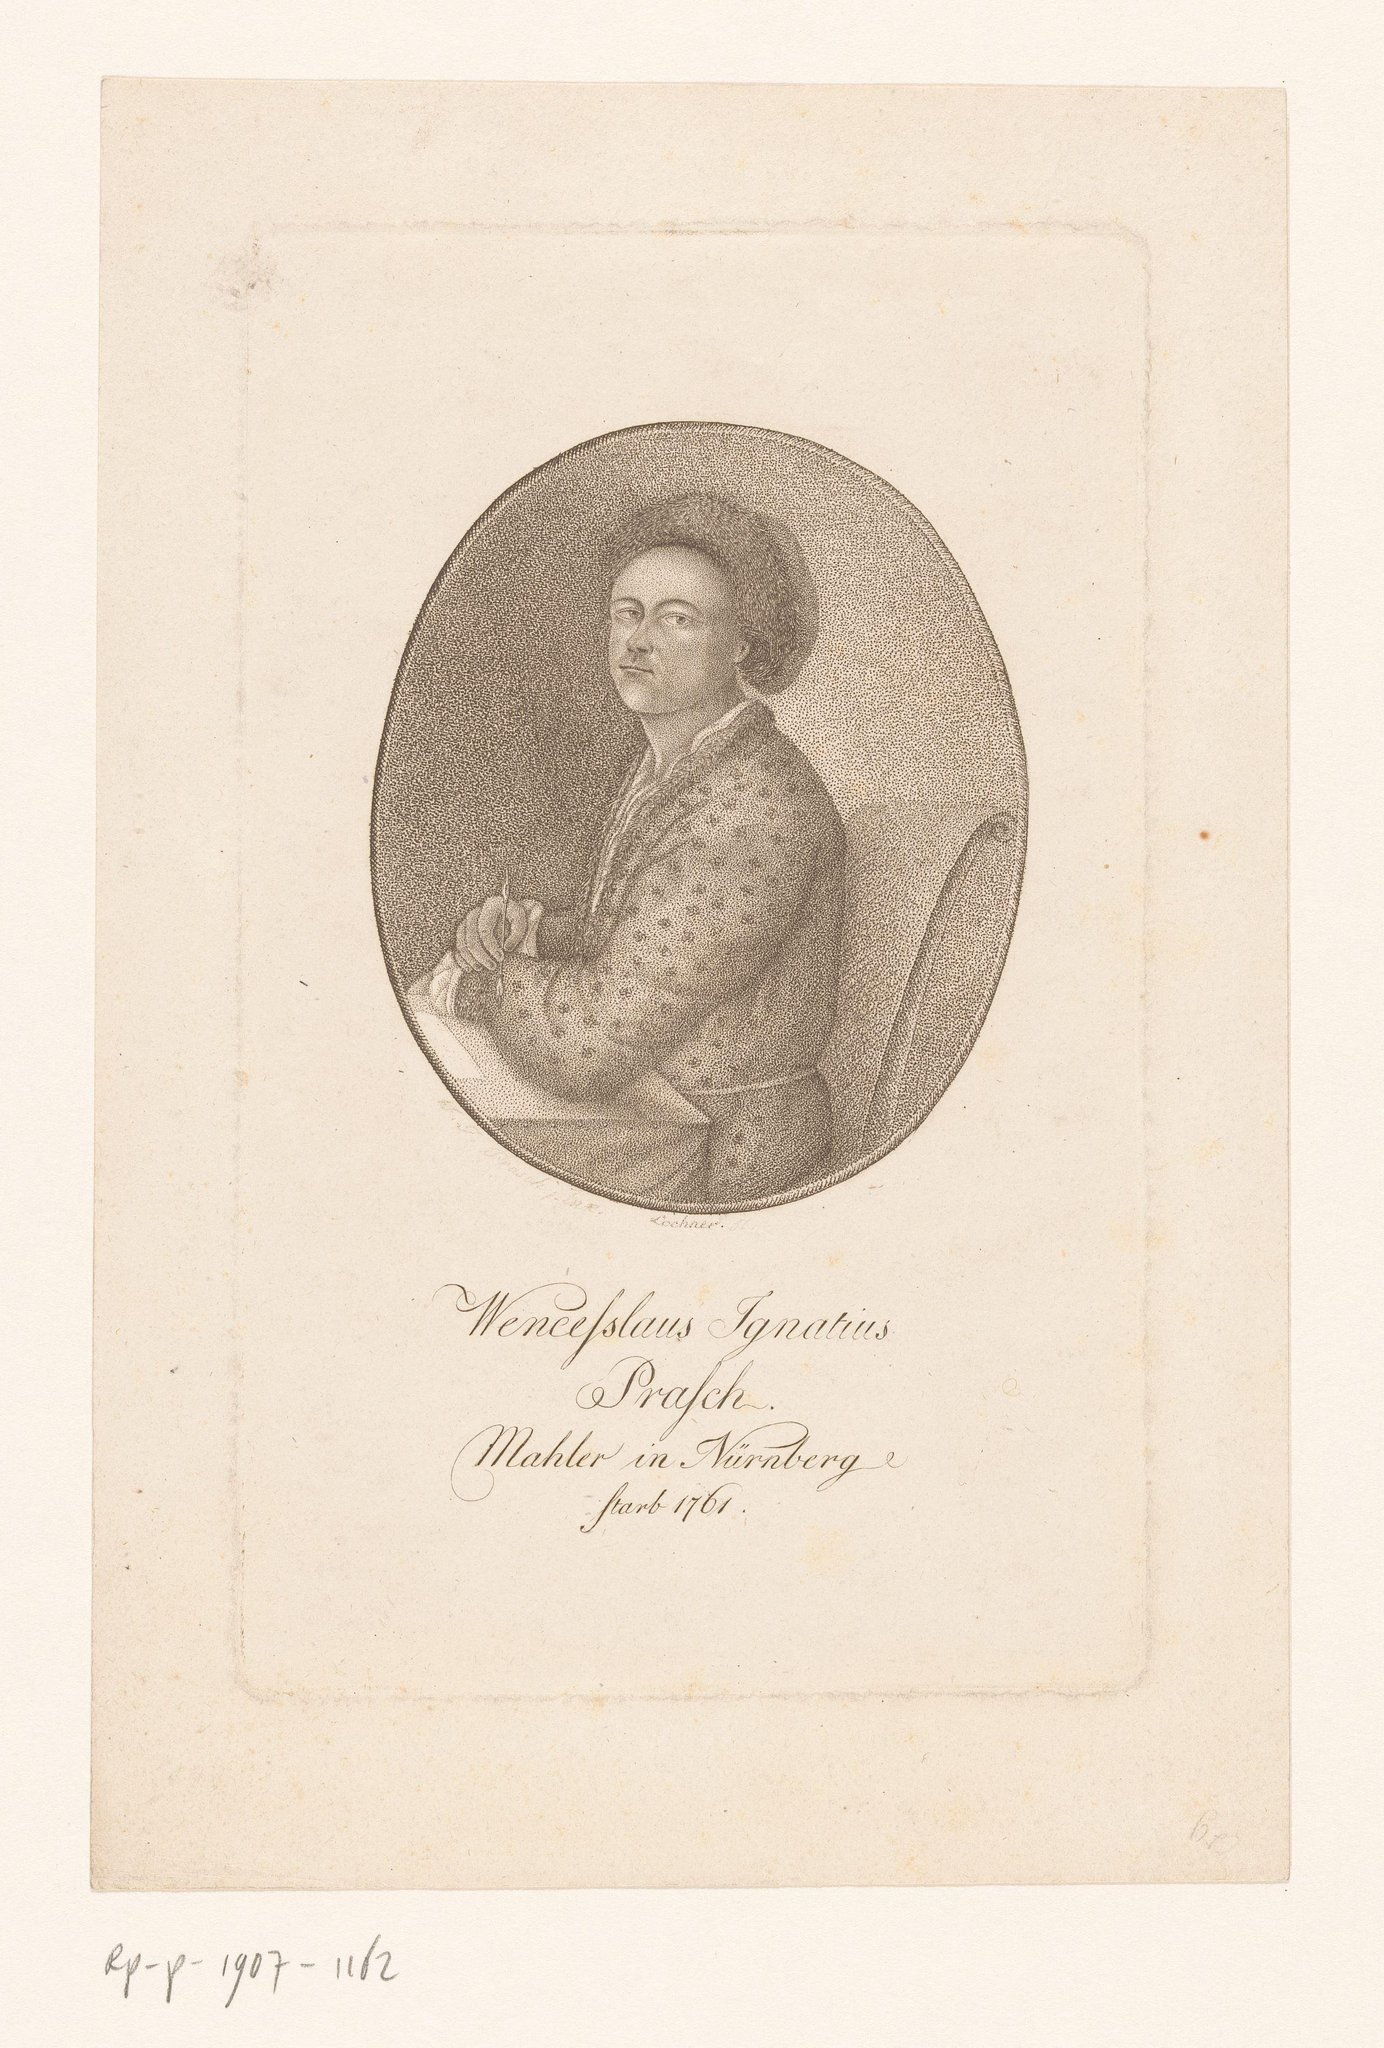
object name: print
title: Portret van Wenzel Ignaz Prasch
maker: carl friedrich lochner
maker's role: print maker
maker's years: 1761-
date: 1761-1799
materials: paper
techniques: stippling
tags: painter, artist, historical persons, portrait, self-portrait of artist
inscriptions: collector's mark: Lugt 2228